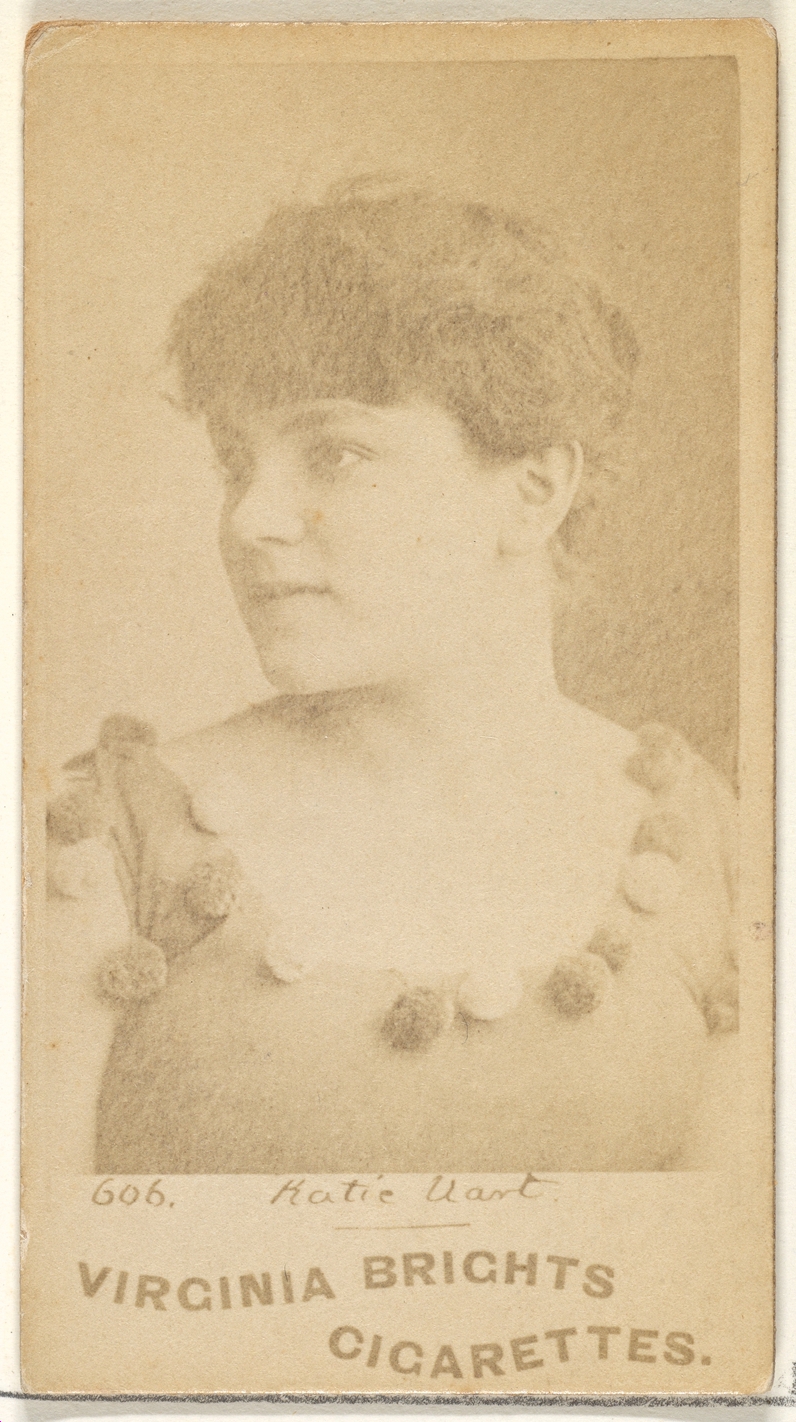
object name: photograph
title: Card 606, Katie Uart, Corsair Co., from the Actors and Actresses series (N45, Type 1) for Virginia Brights Cigarettes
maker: allen & ginter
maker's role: publisher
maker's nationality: american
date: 1888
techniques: albumen silver print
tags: portraits,women,actresses